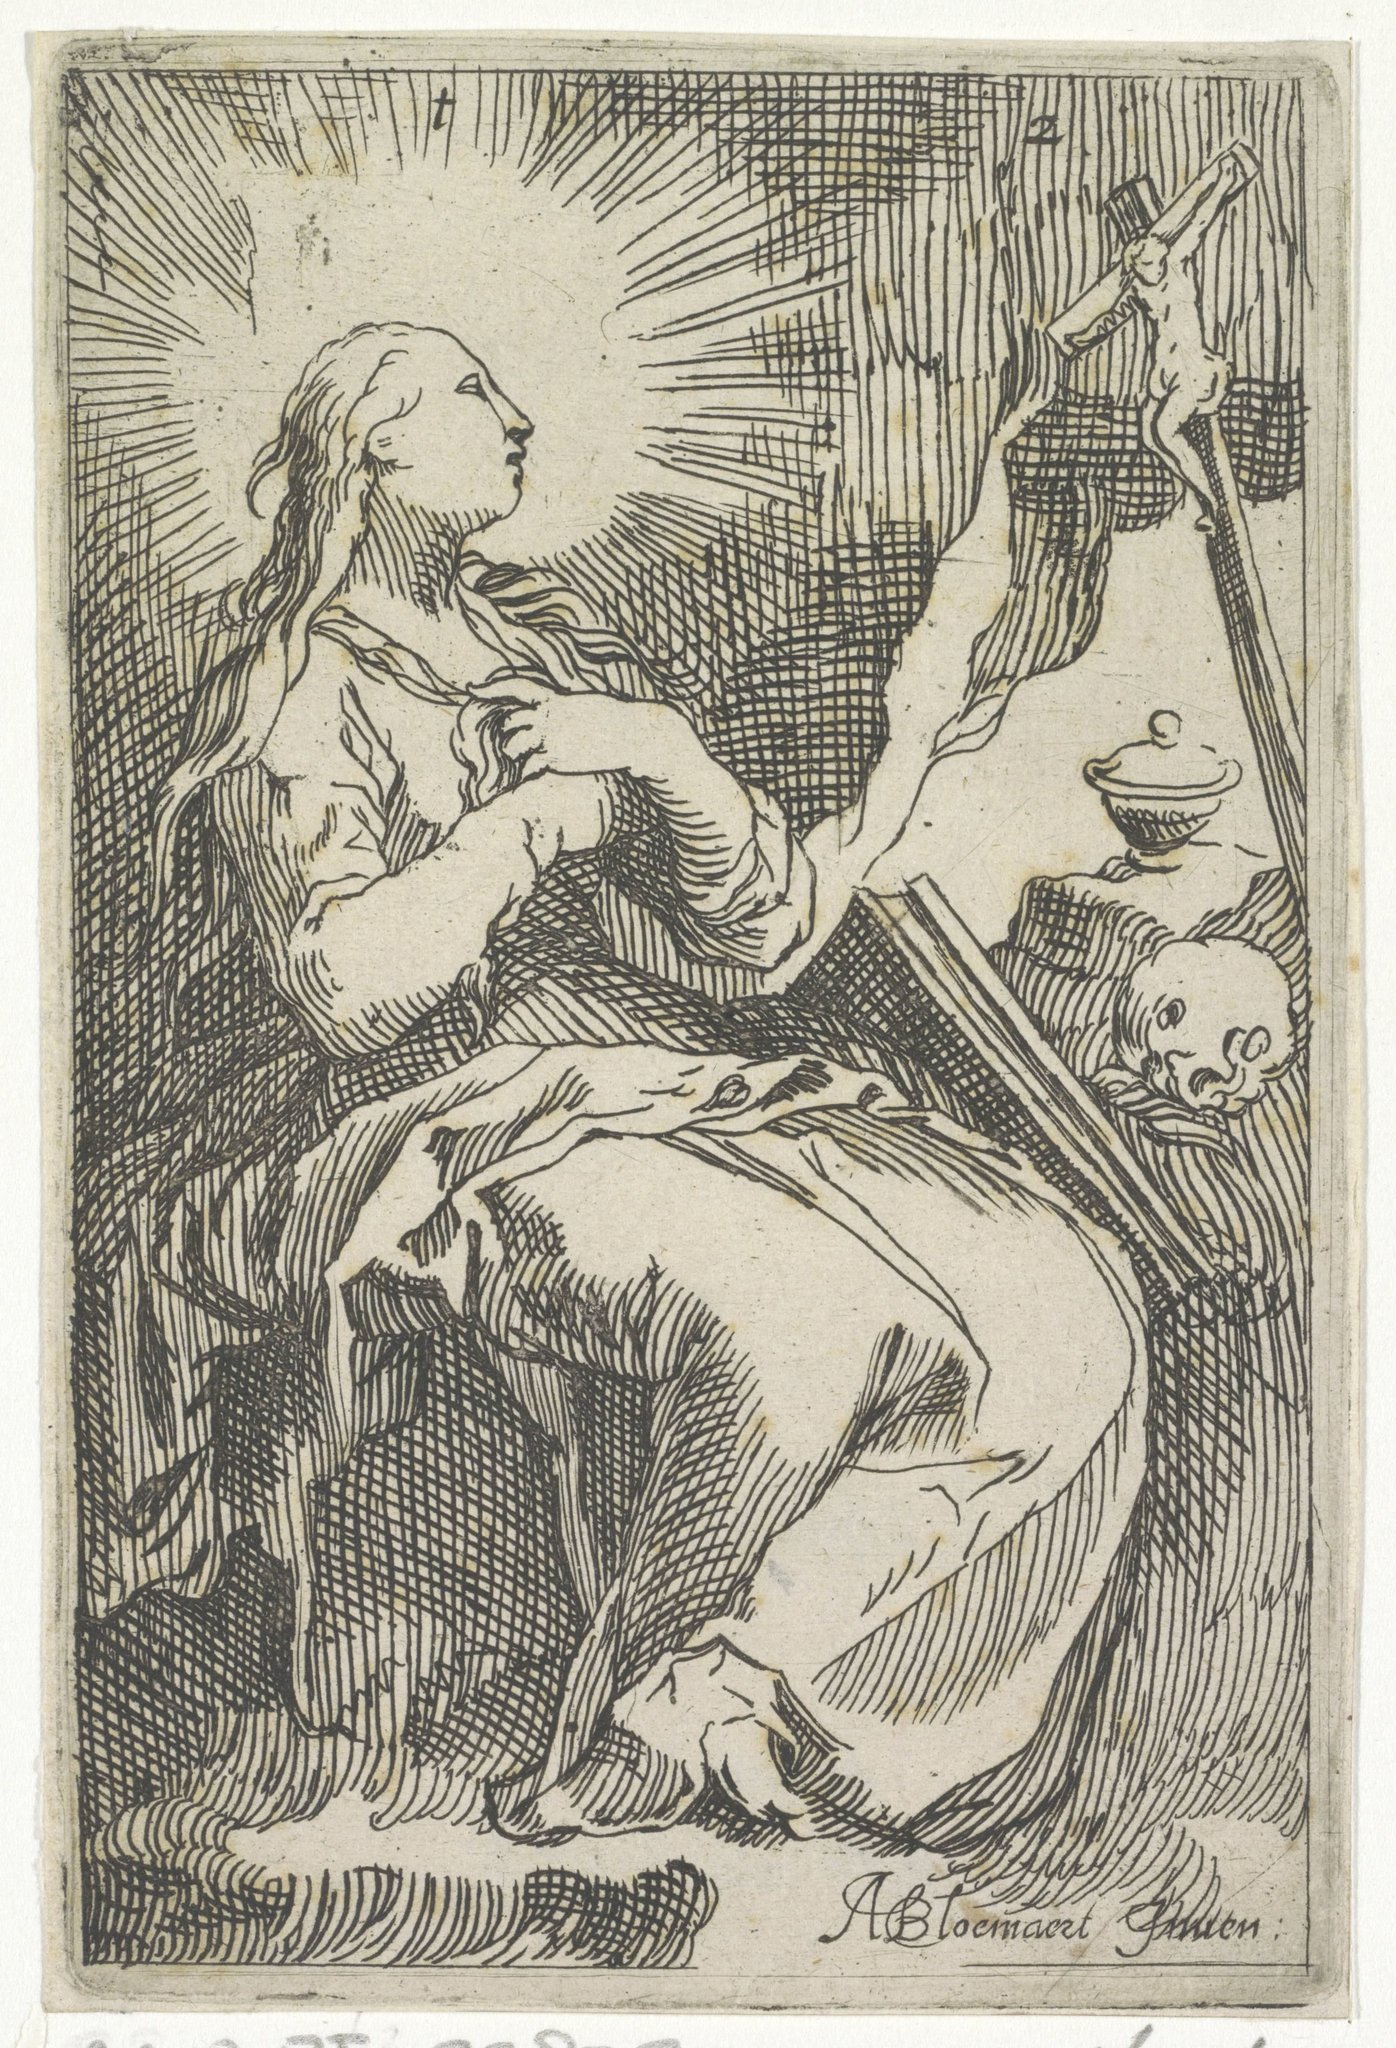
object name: print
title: Boetvaardige Maria Magdalena in de grot voor crucifix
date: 1610-1615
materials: paper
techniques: etching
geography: netherlands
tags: the penitent harlot mary magdalene; possible attributes: book (or scroll), crown, crown of thorns, crucifix, jar of ointment, mirror, musical instrument, palm-branch, rosary, scourge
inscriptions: collector's mark: Lugt 240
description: Er zijn drie verschillende platen met dezelfde voostelling gemaakt. Dit is de tweede staat van plaat C.